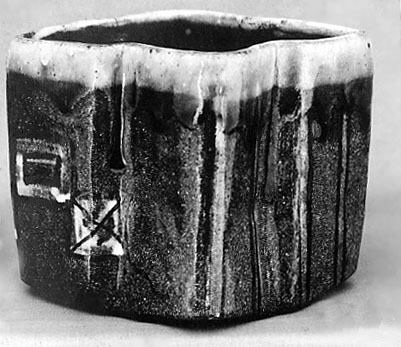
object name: teabowl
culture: japanese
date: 1801-1900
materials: clay, glaze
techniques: overglaze